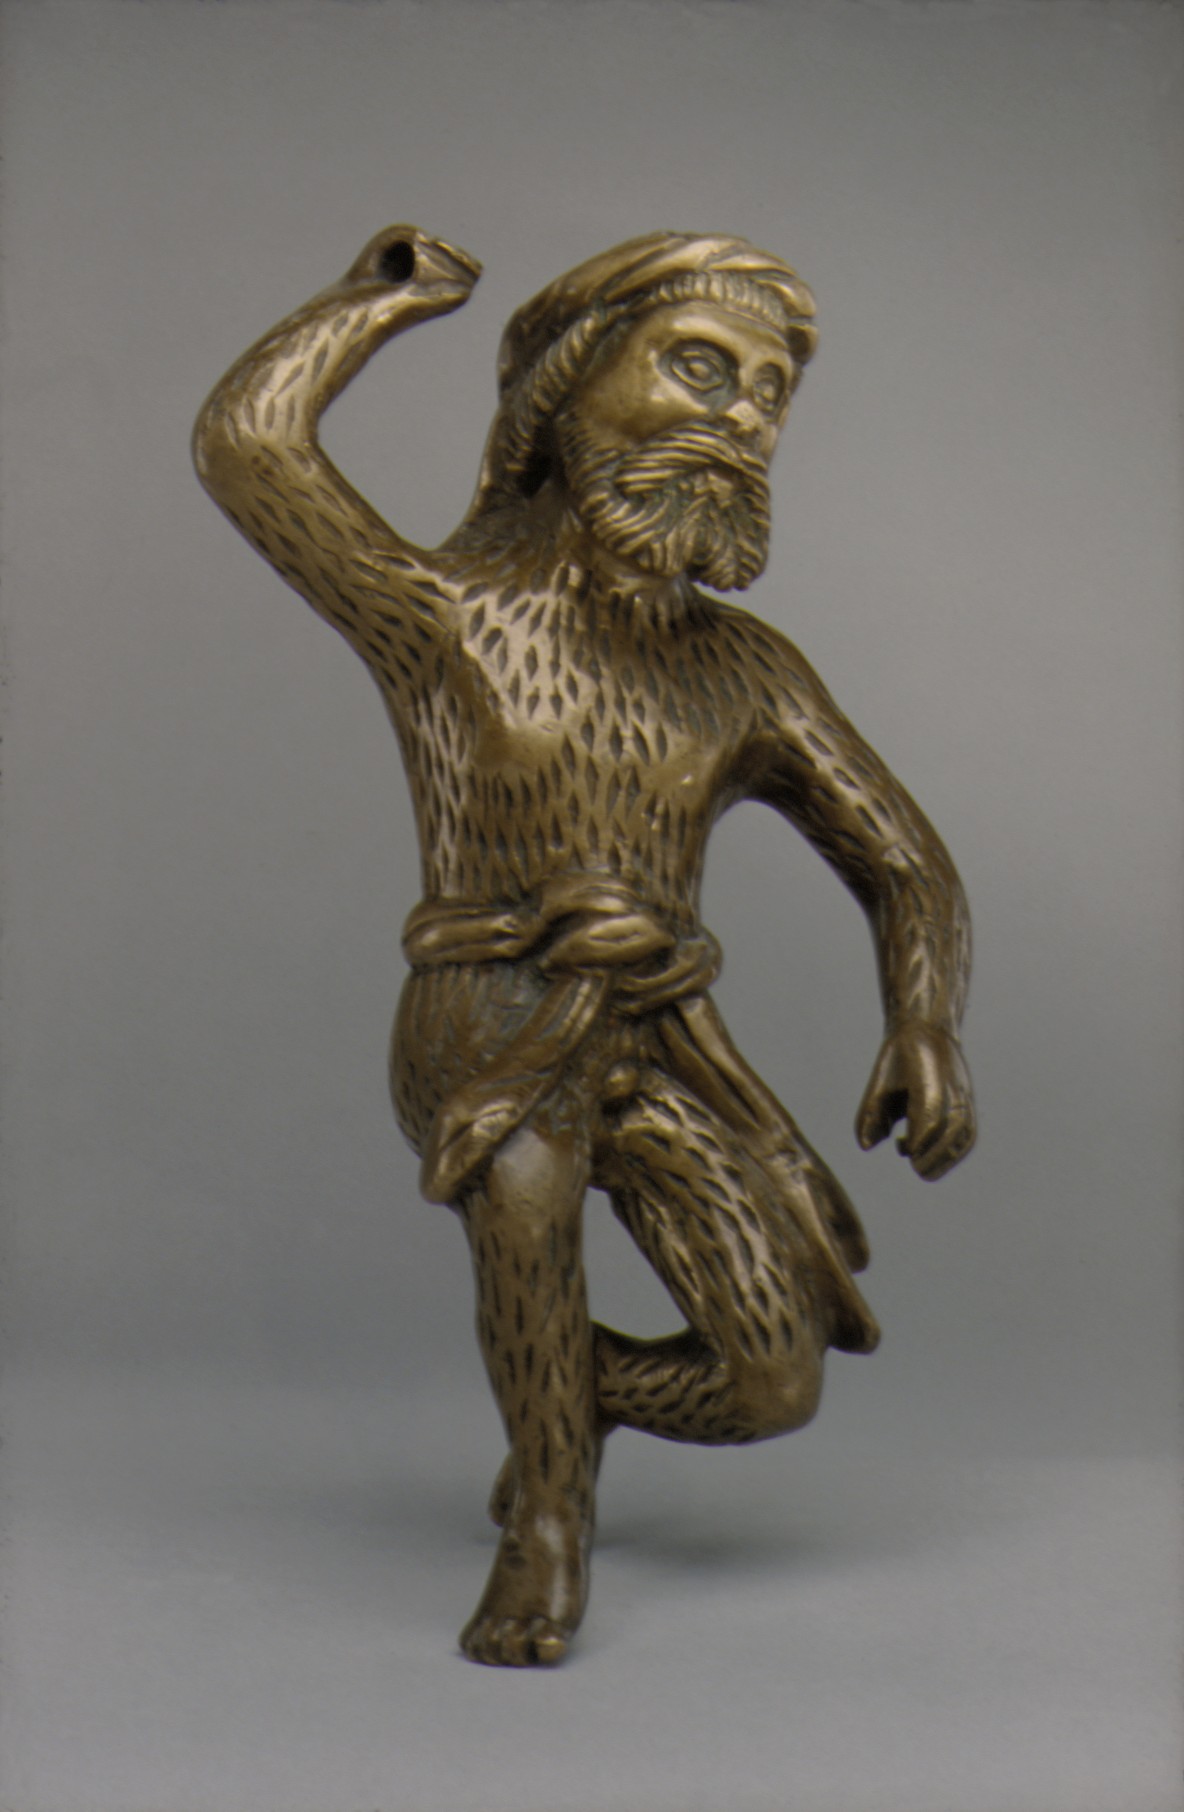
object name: figure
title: Wild Man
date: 1501-1600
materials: brass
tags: men